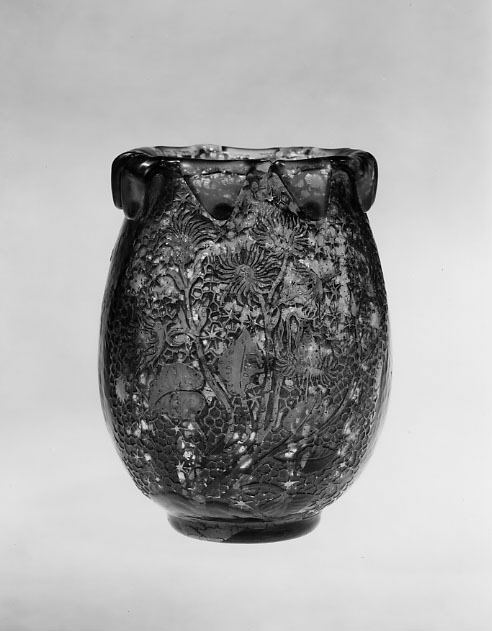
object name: vase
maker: emile gallé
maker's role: designer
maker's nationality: french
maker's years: 1846-1904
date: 1900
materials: glass